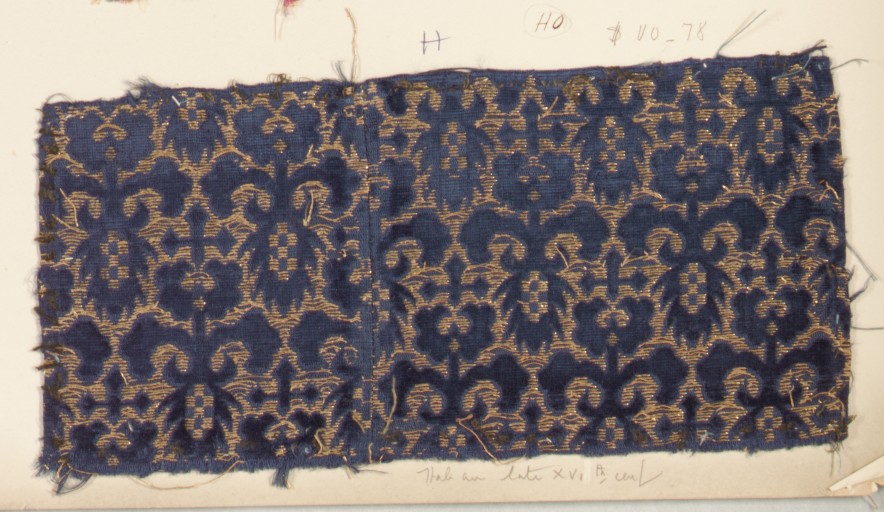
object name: fragment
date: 1567-1600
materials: metal thread, silk